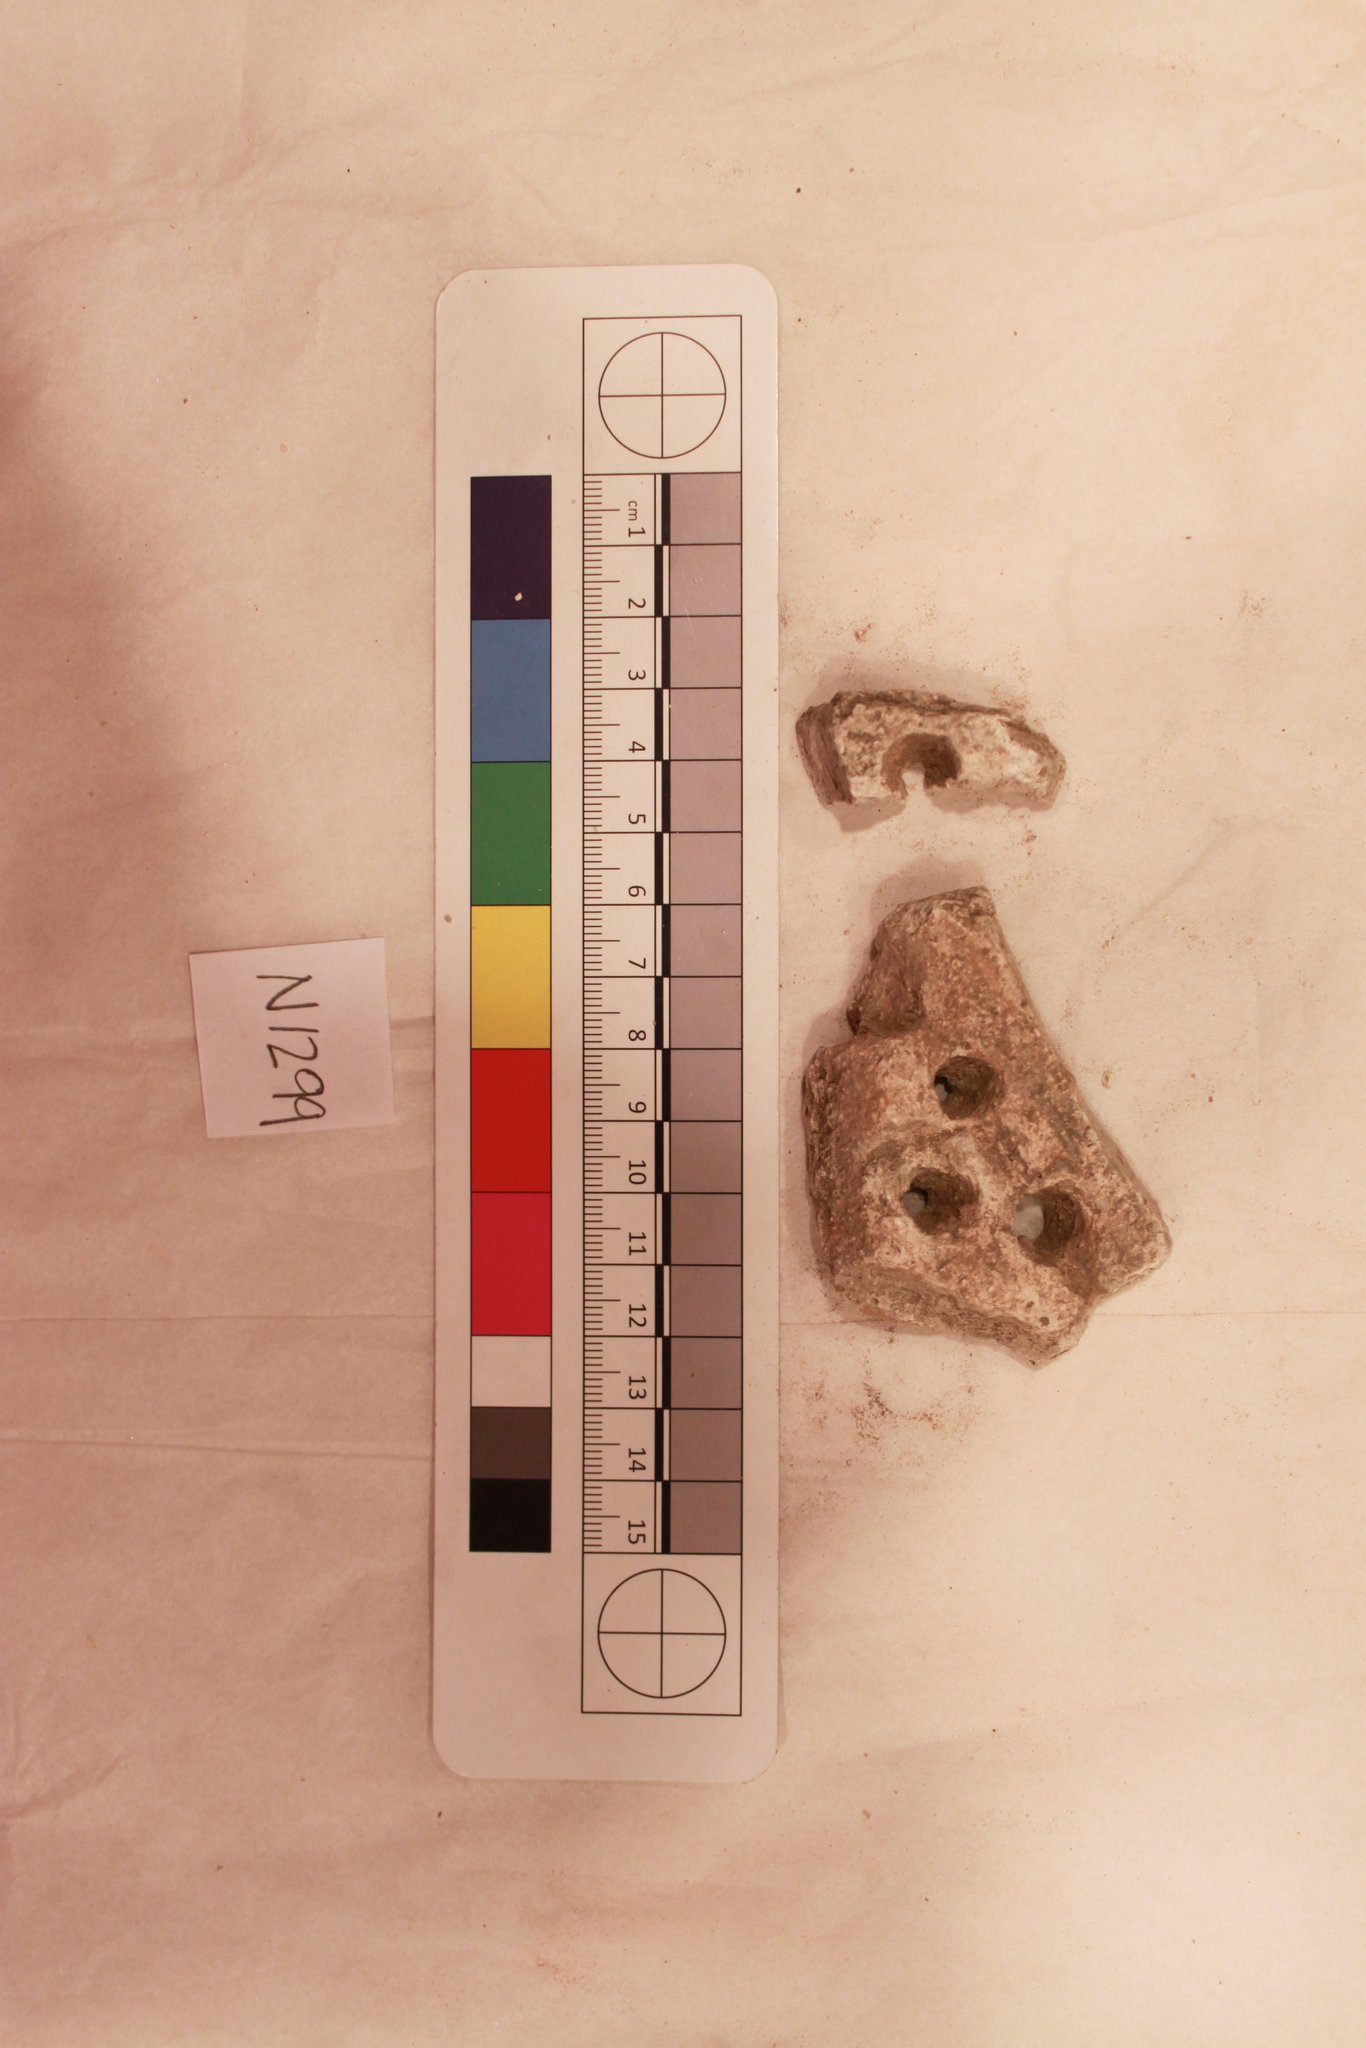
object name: fragment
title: Stucco Fragment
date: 701-1200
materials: plaster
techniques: carving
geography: iran